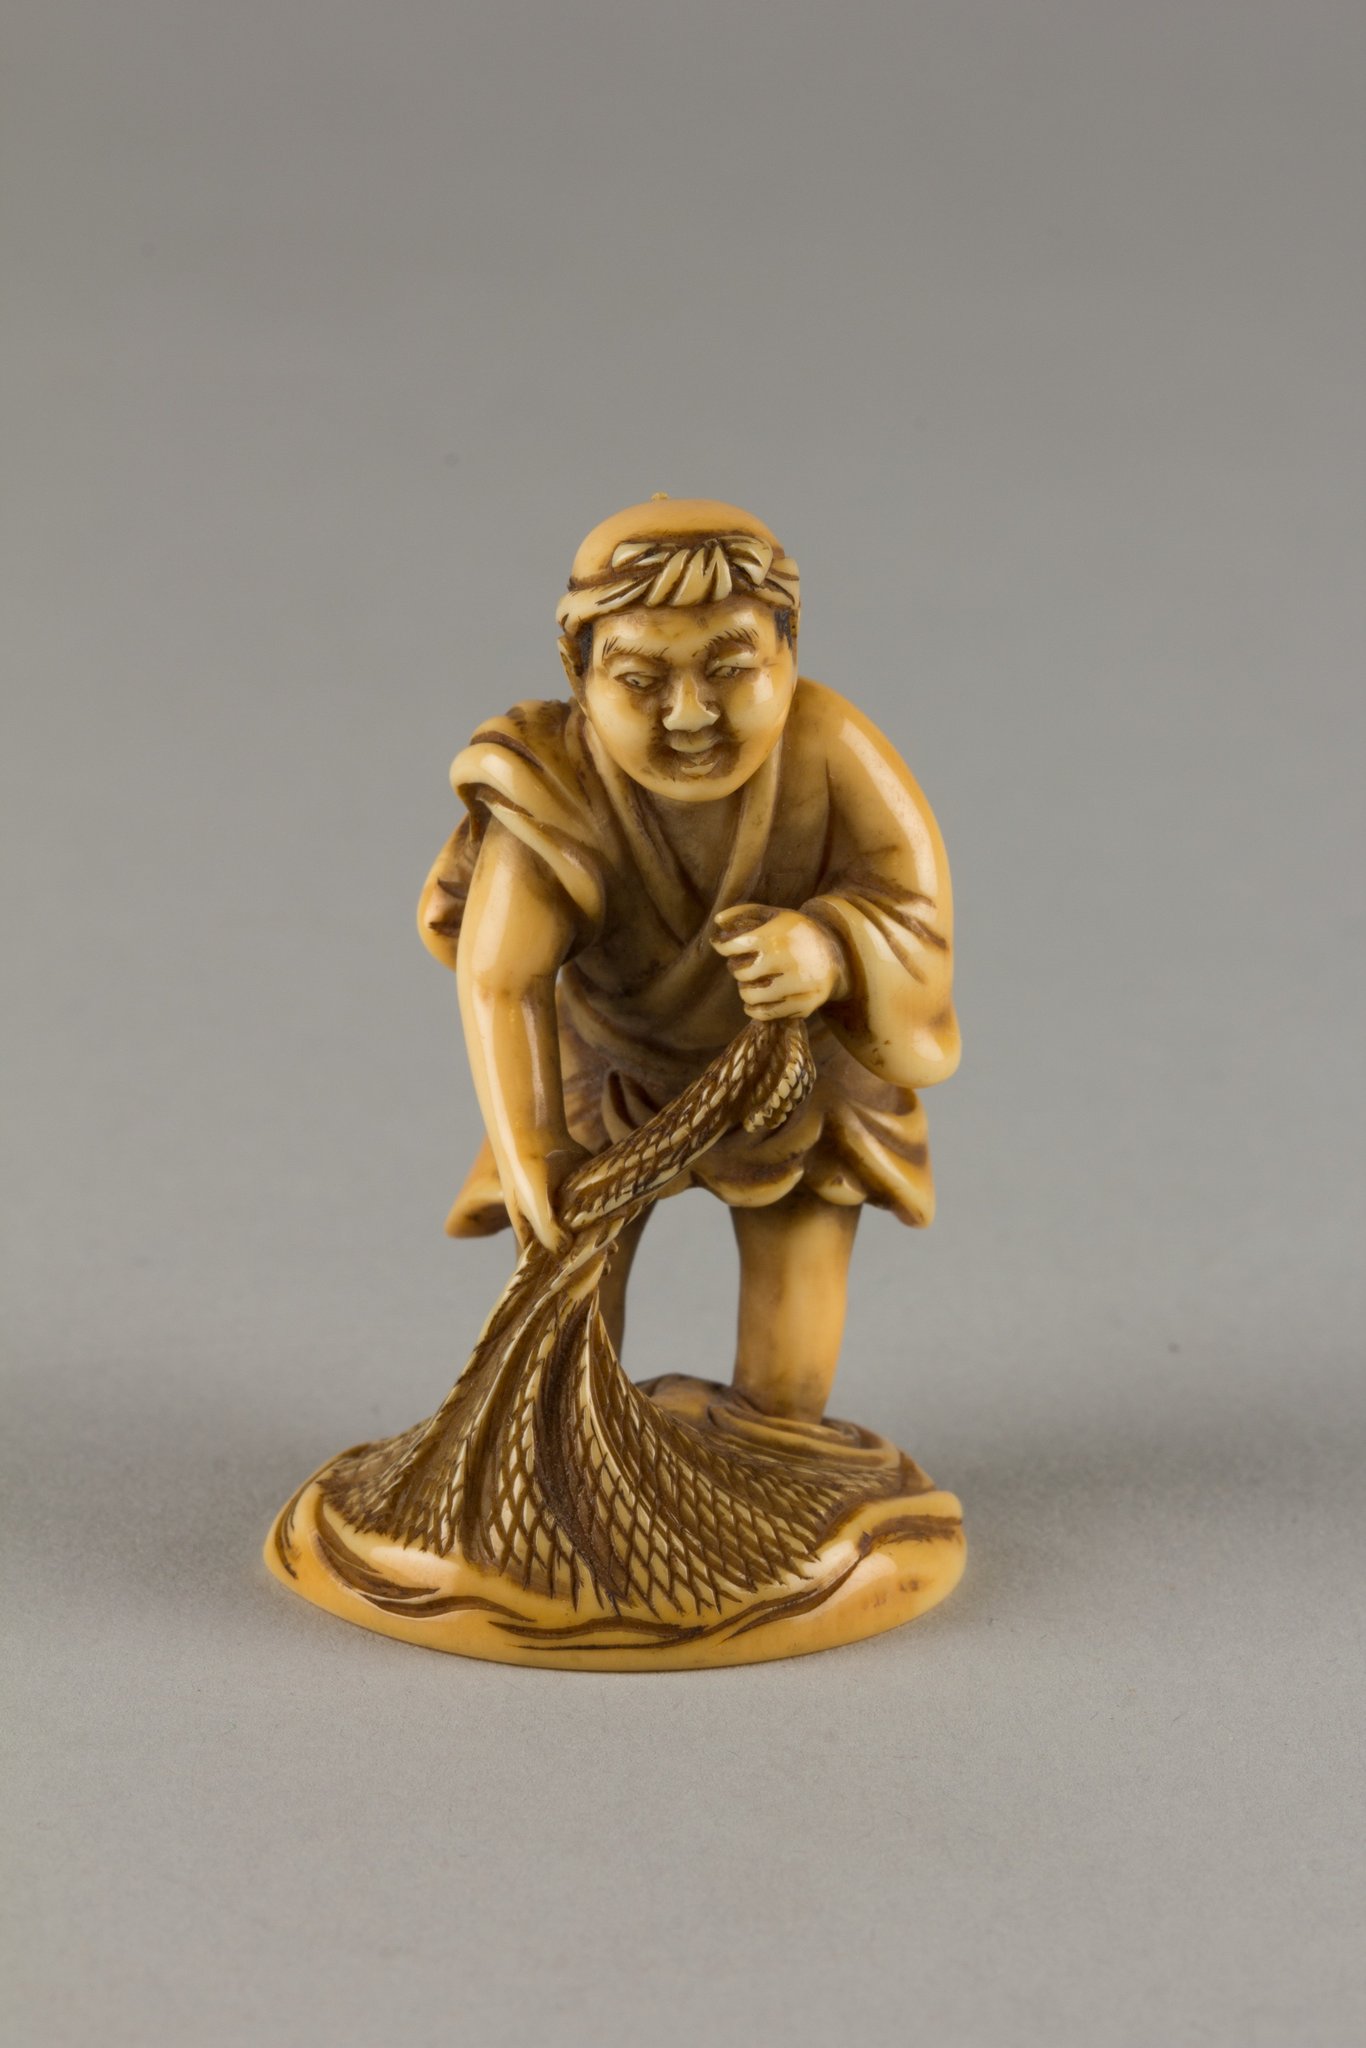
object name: netsuke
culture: japanese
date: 1801-1900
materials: ivory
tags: men